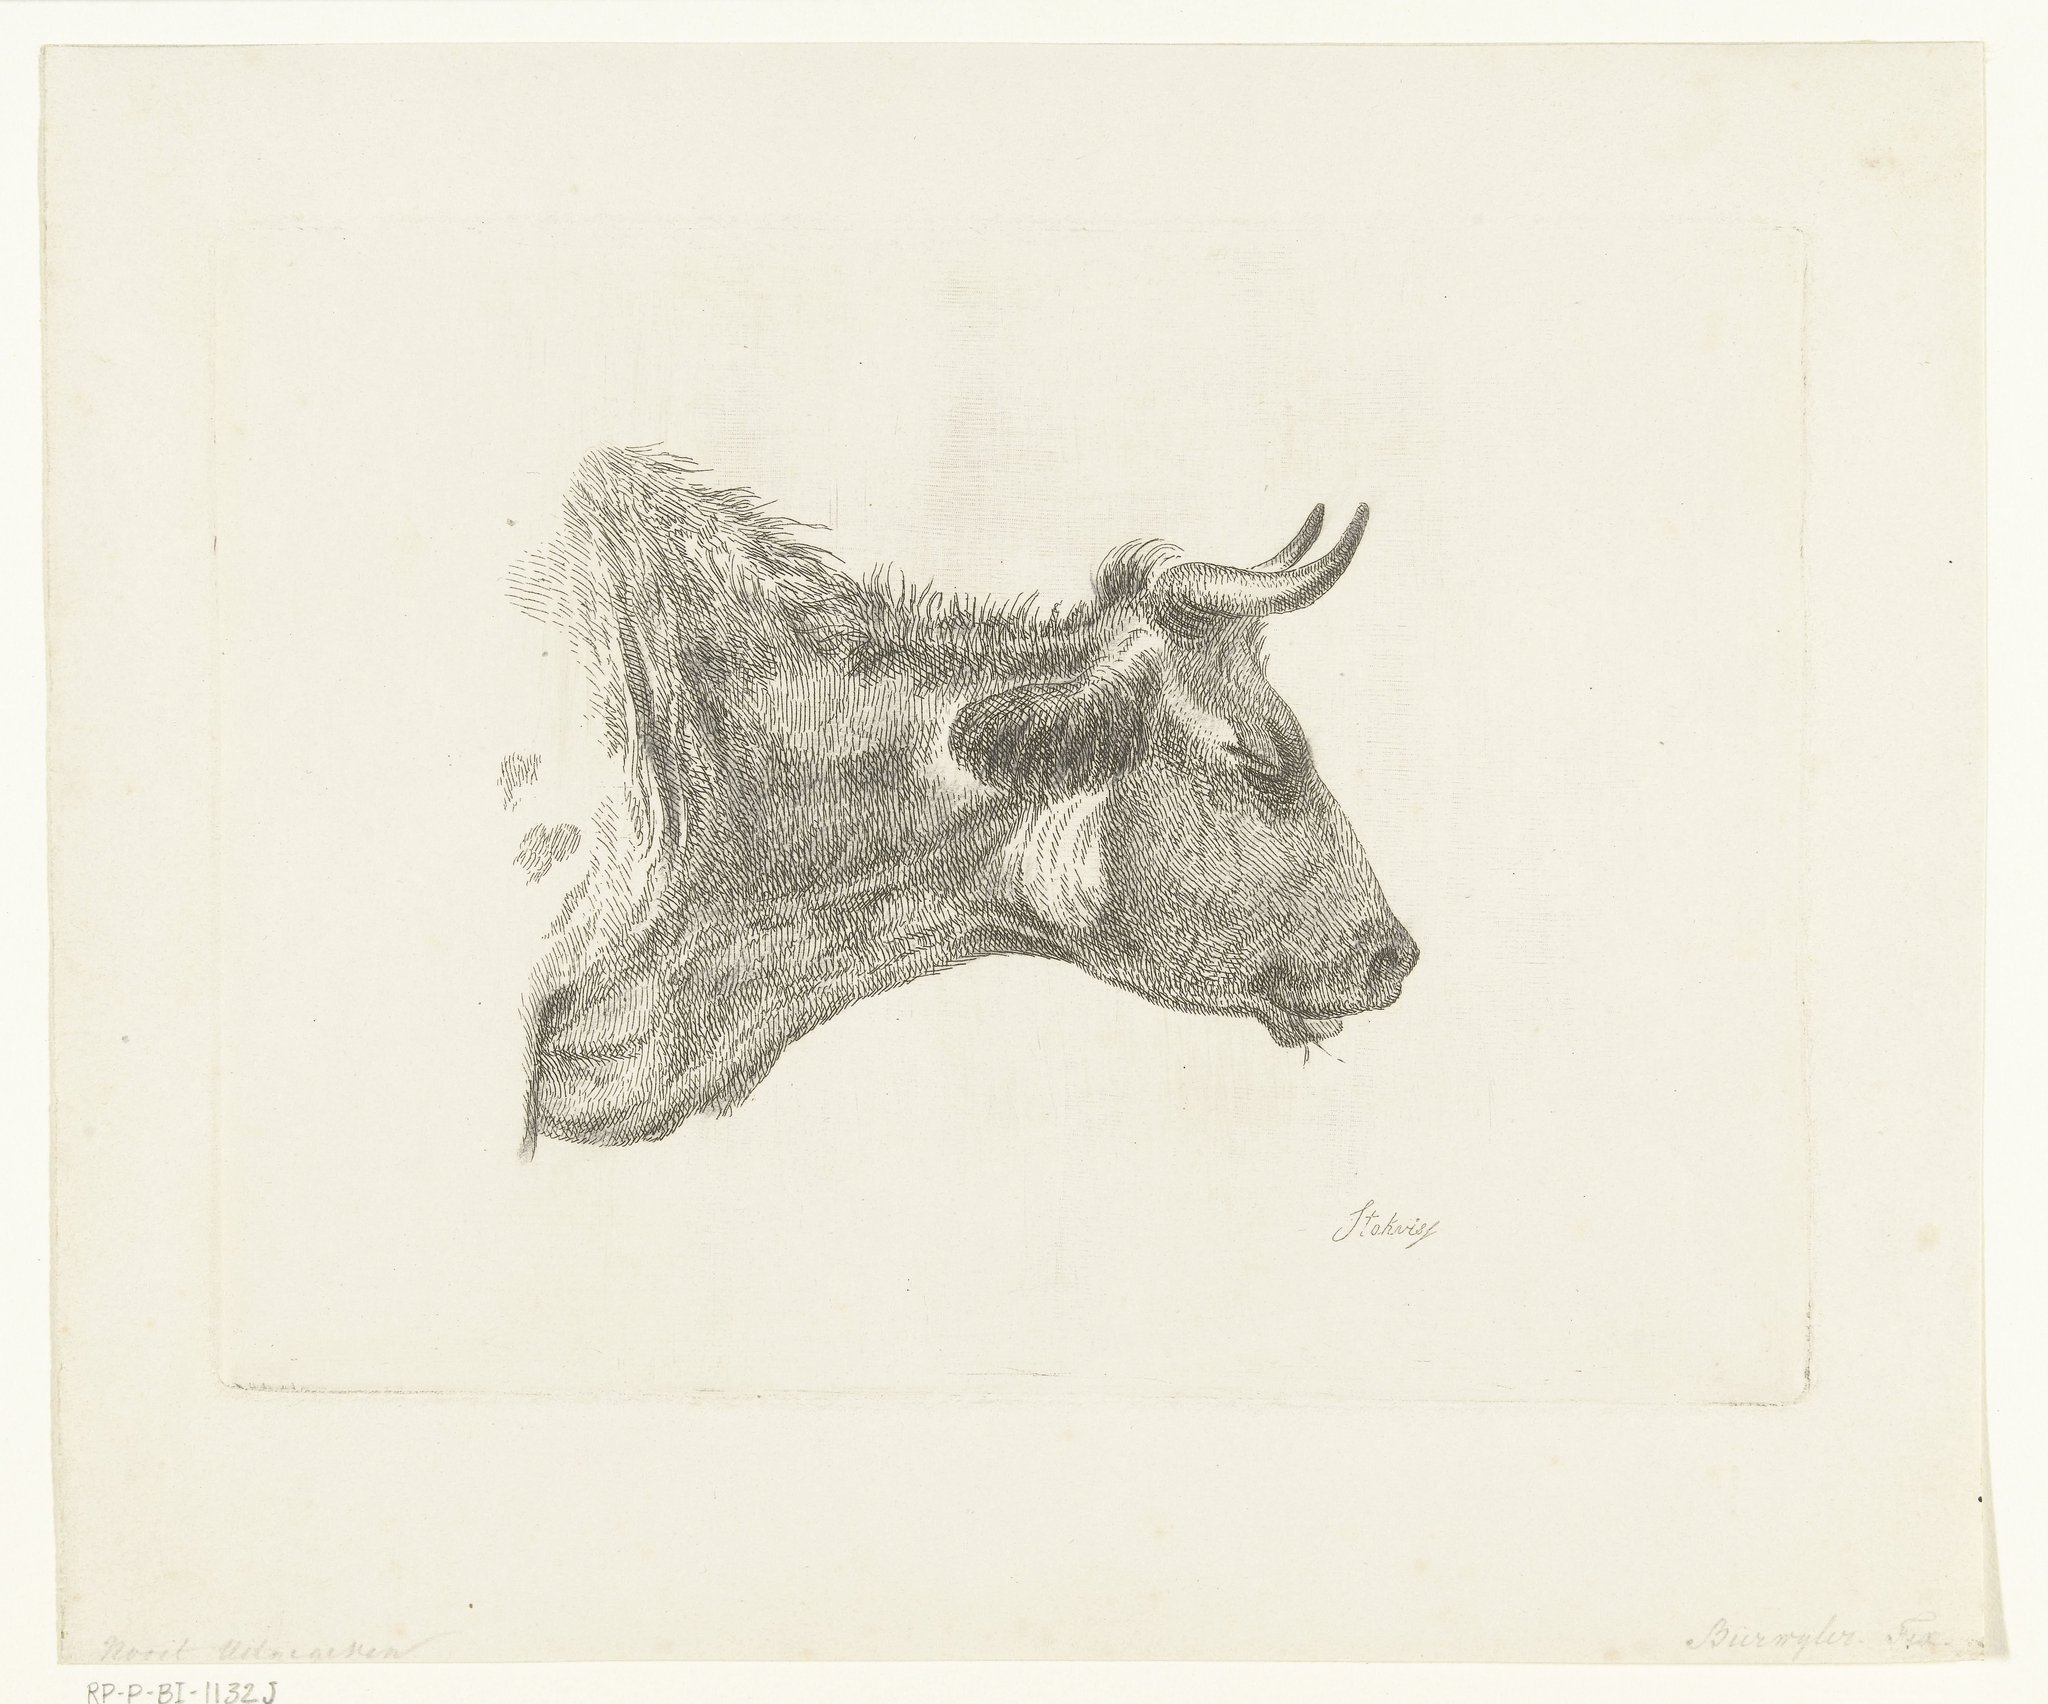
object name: print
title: Kop van koe met grasspriet in bek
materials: paper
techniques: etching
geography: amsterdam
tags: cow, animals (+ head of an animal)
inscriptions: collector's mark: Lugt 2228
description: Prent naar ontwerp van Hendrik Stokvisch.